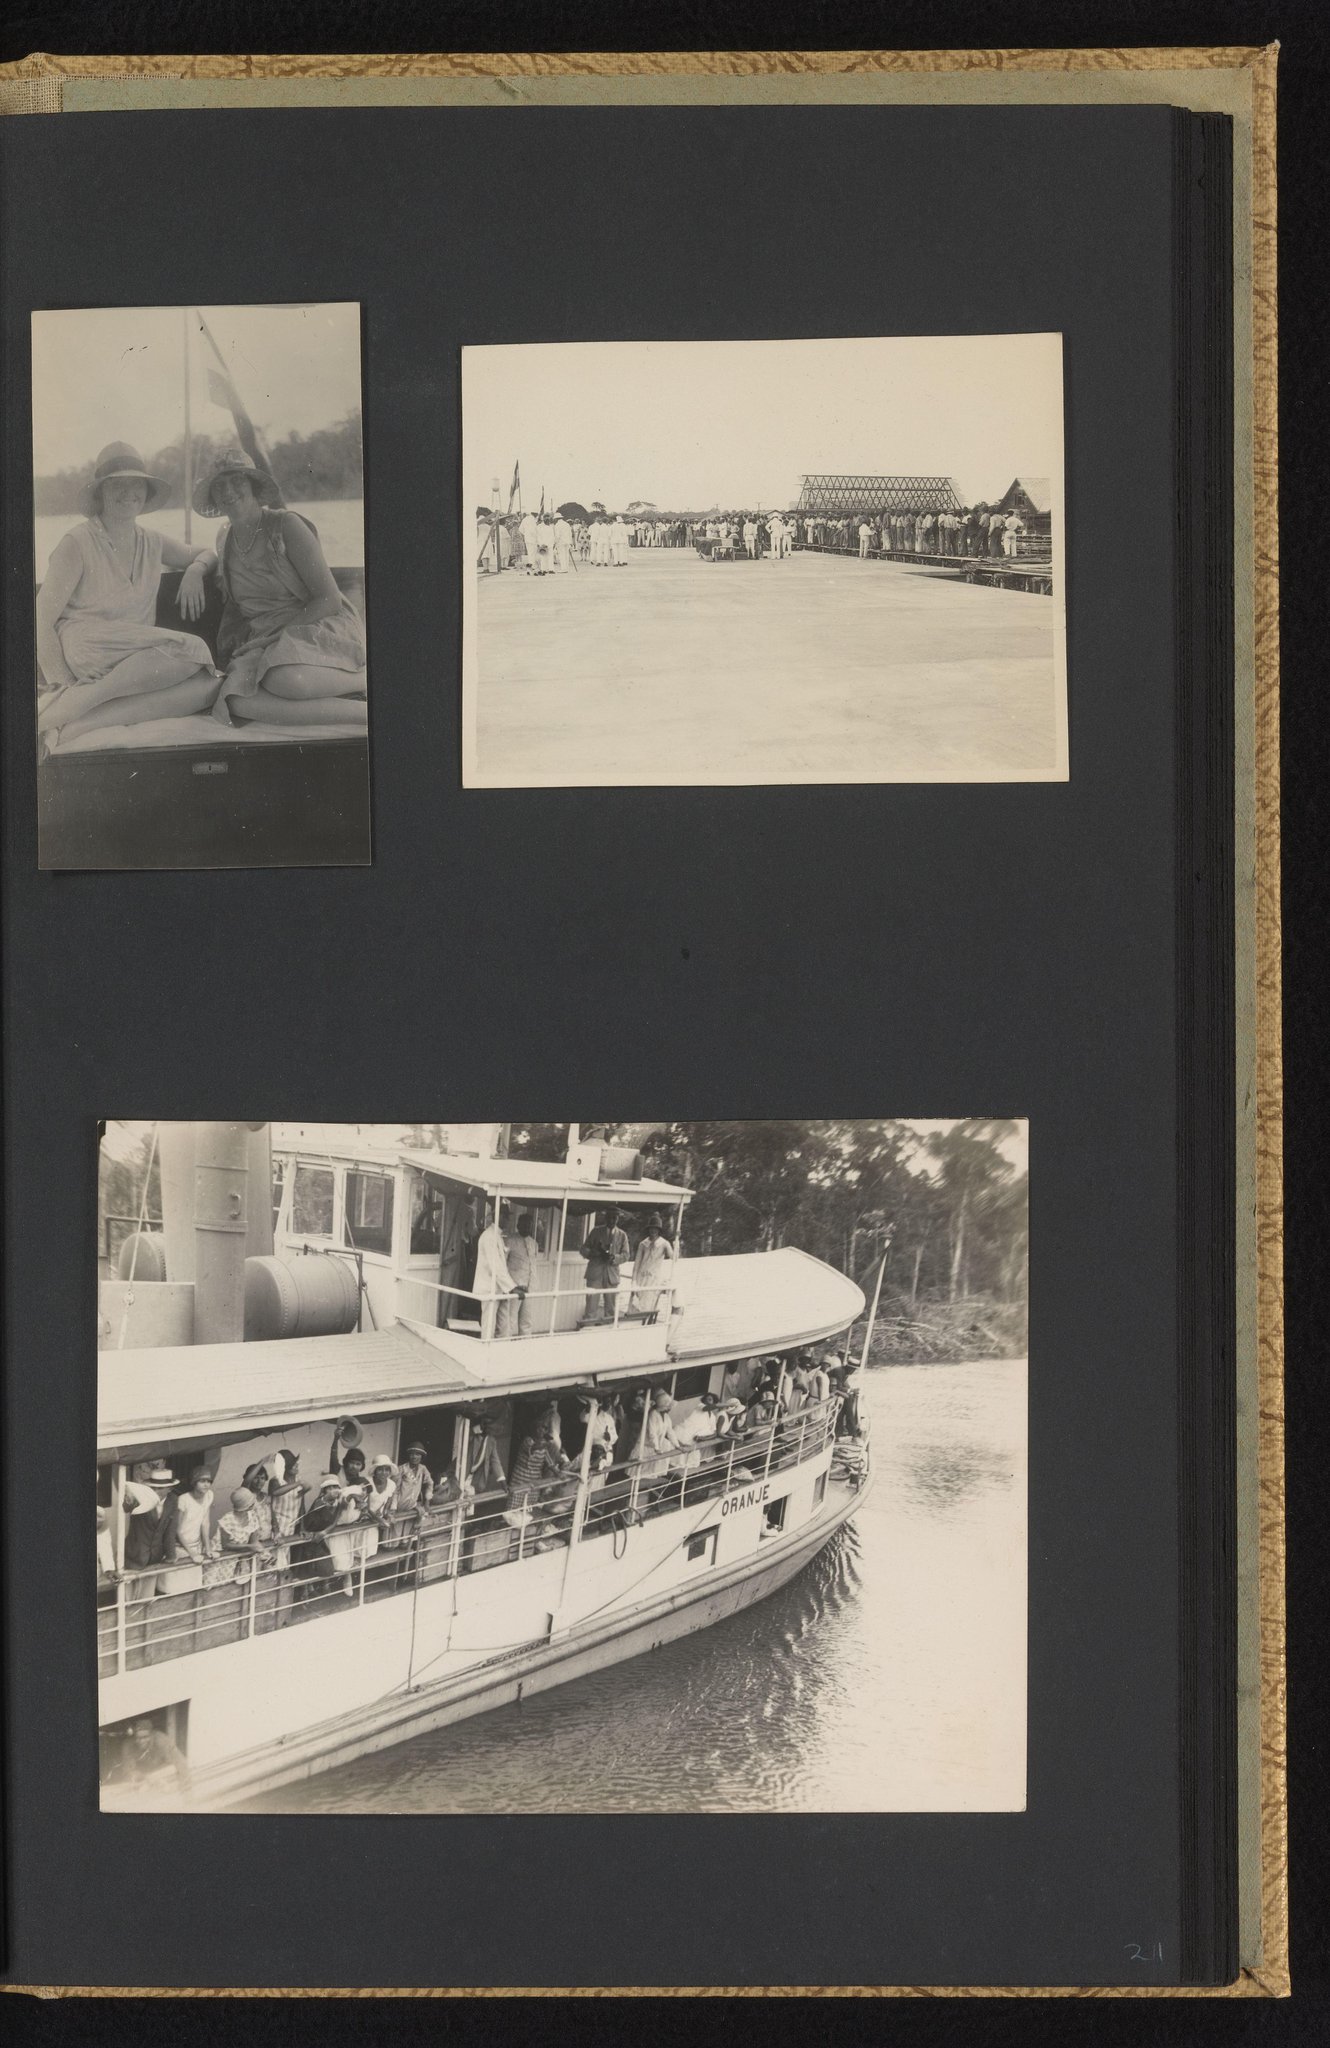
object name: photograph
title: Op een boot en ceremonie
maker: Anonymous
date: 1929-1930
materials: paper, photographic support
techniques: gelatin silver print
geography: suriname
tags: passengers ~ ship, ferry, public festivities, steamship, motorship, suriname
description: Albumblad met drie foto's: twee vrouwen op een boot, het passagiersschip of veerboot 'Oranje' en een menigte verzameld op een platform voor een ceremonie. Onderdeel van het album van de familie Guilonard over de bauxietwinning in Moengo en Albina in Suriname in de jaren 1929-1930.